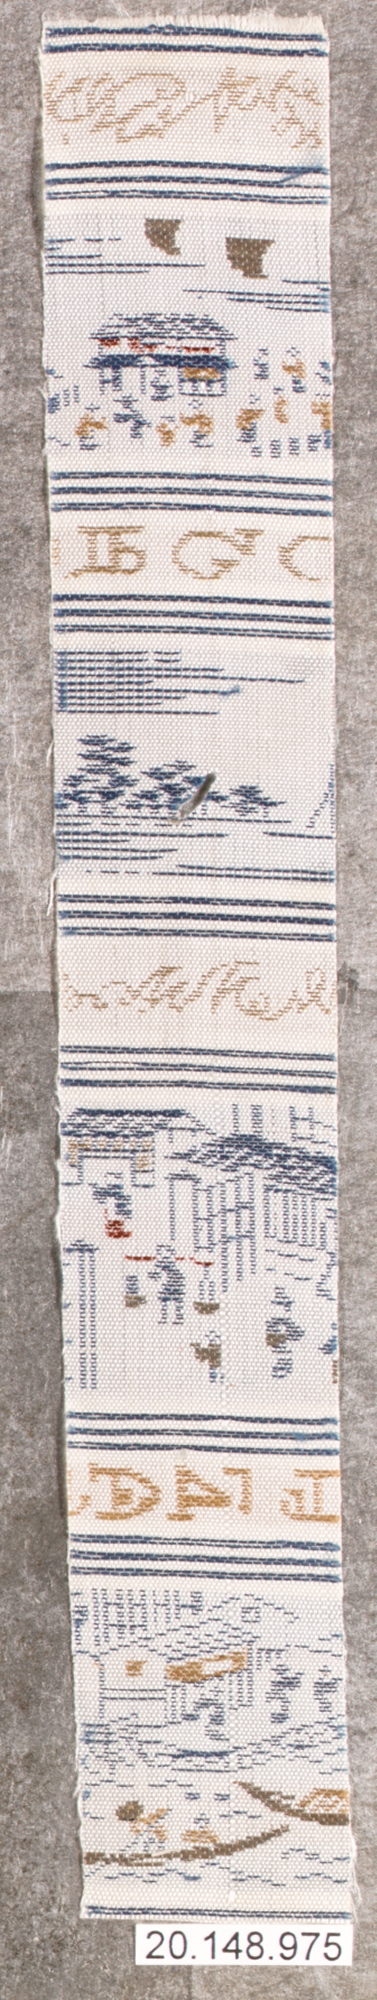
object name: piece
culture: japanese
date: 1701-1800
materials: silk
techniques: compound weave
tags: houses,boats